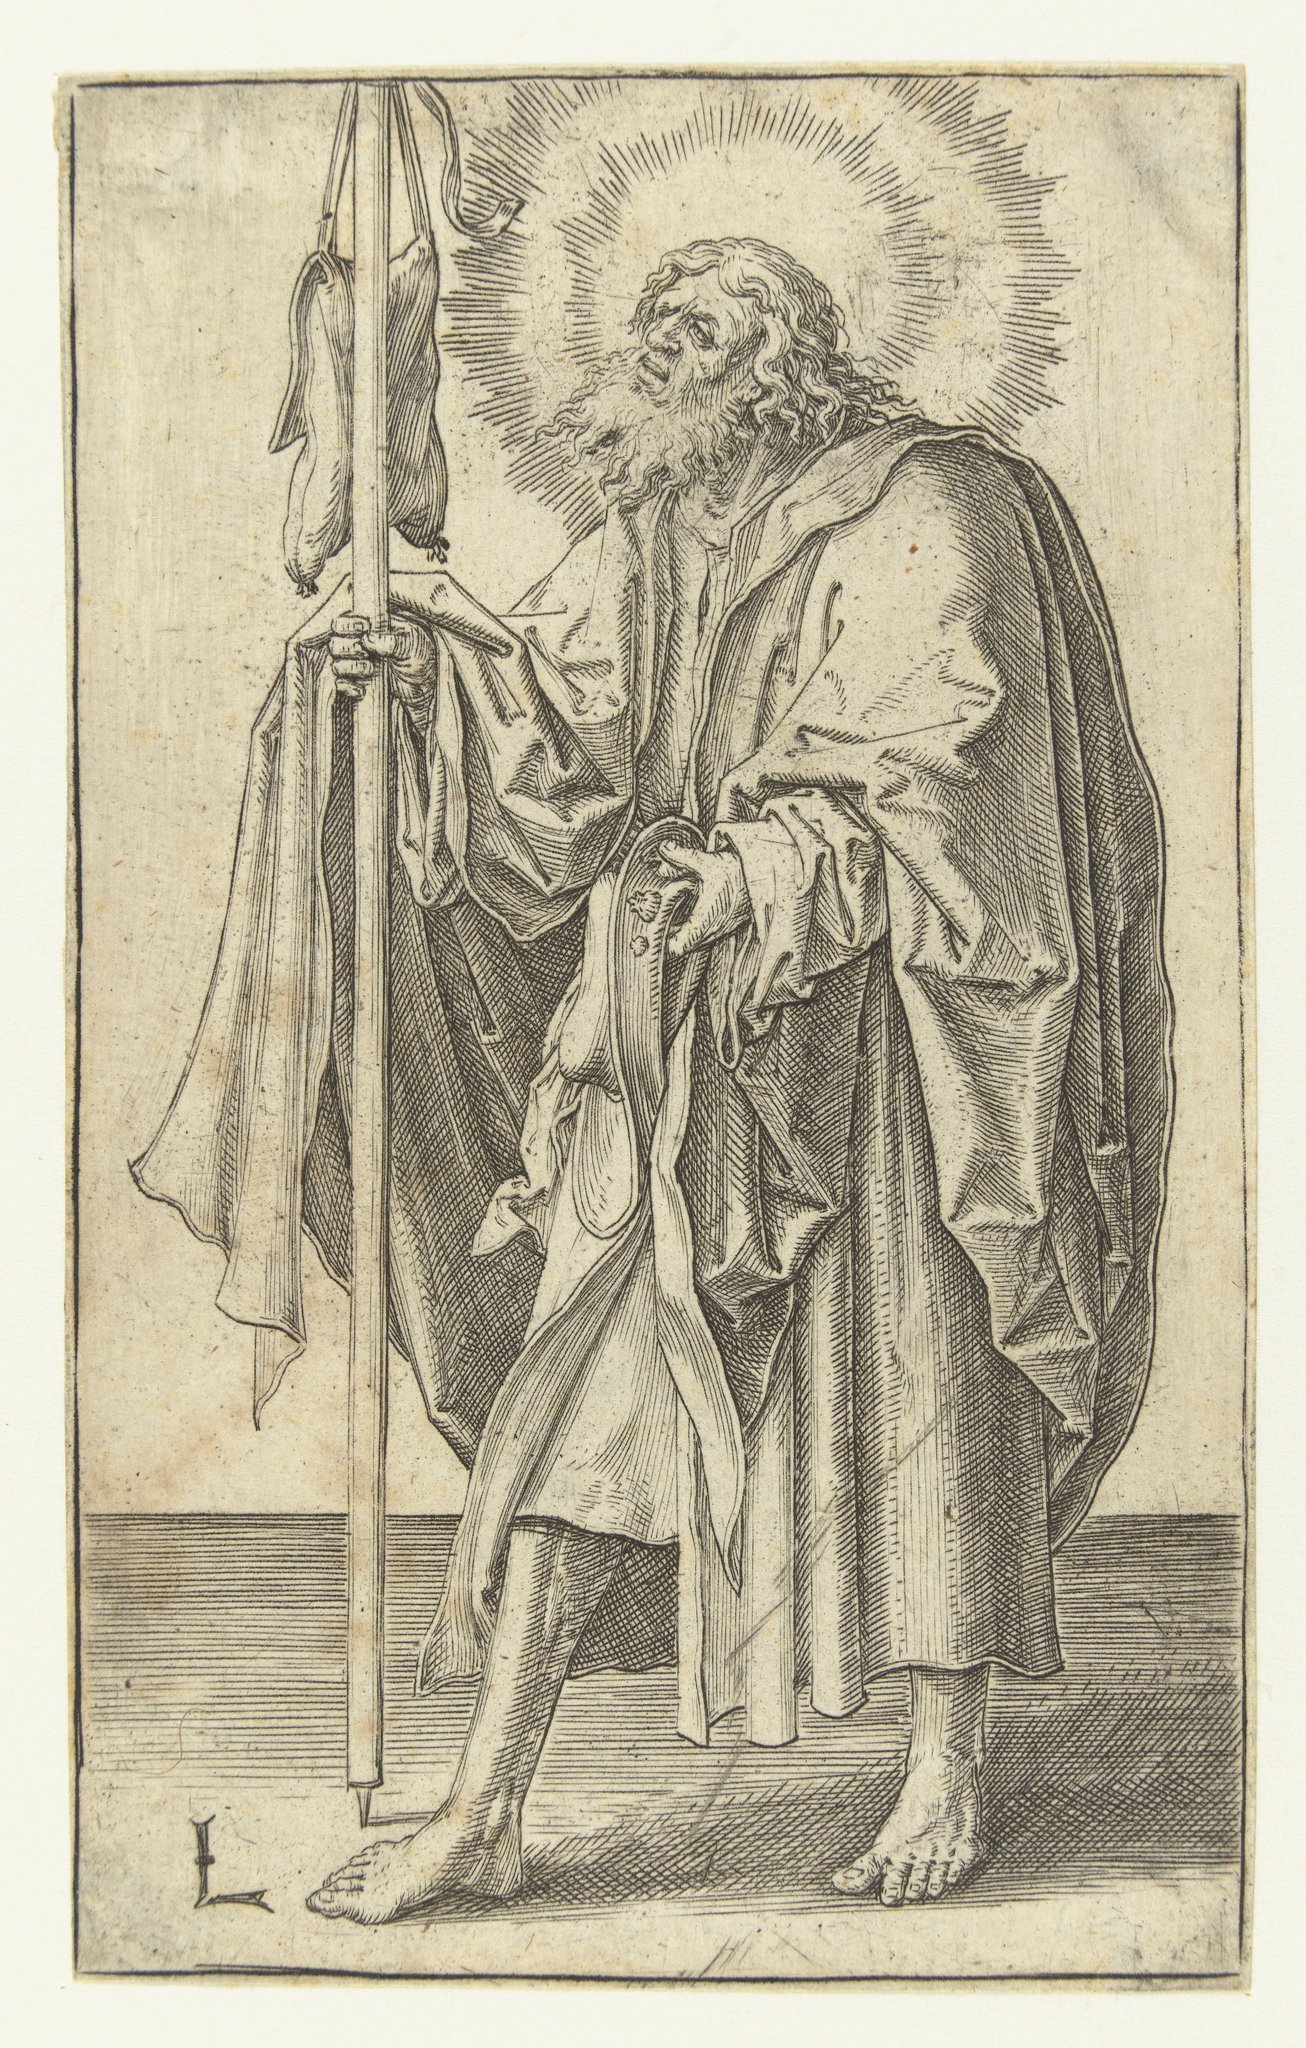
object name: print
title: Christus en de apostelen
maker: lucas van leyden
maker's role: draughtsman, painter, print maker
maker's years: 1494-1533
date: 1508-1512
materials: paper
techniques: engraving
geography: low countries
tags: the apostle james the great; possible attributes: book, pilgrim's cloak, hat, shell, staff, and wallet, scroll, sword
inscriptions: collector's mark: Lugt 11